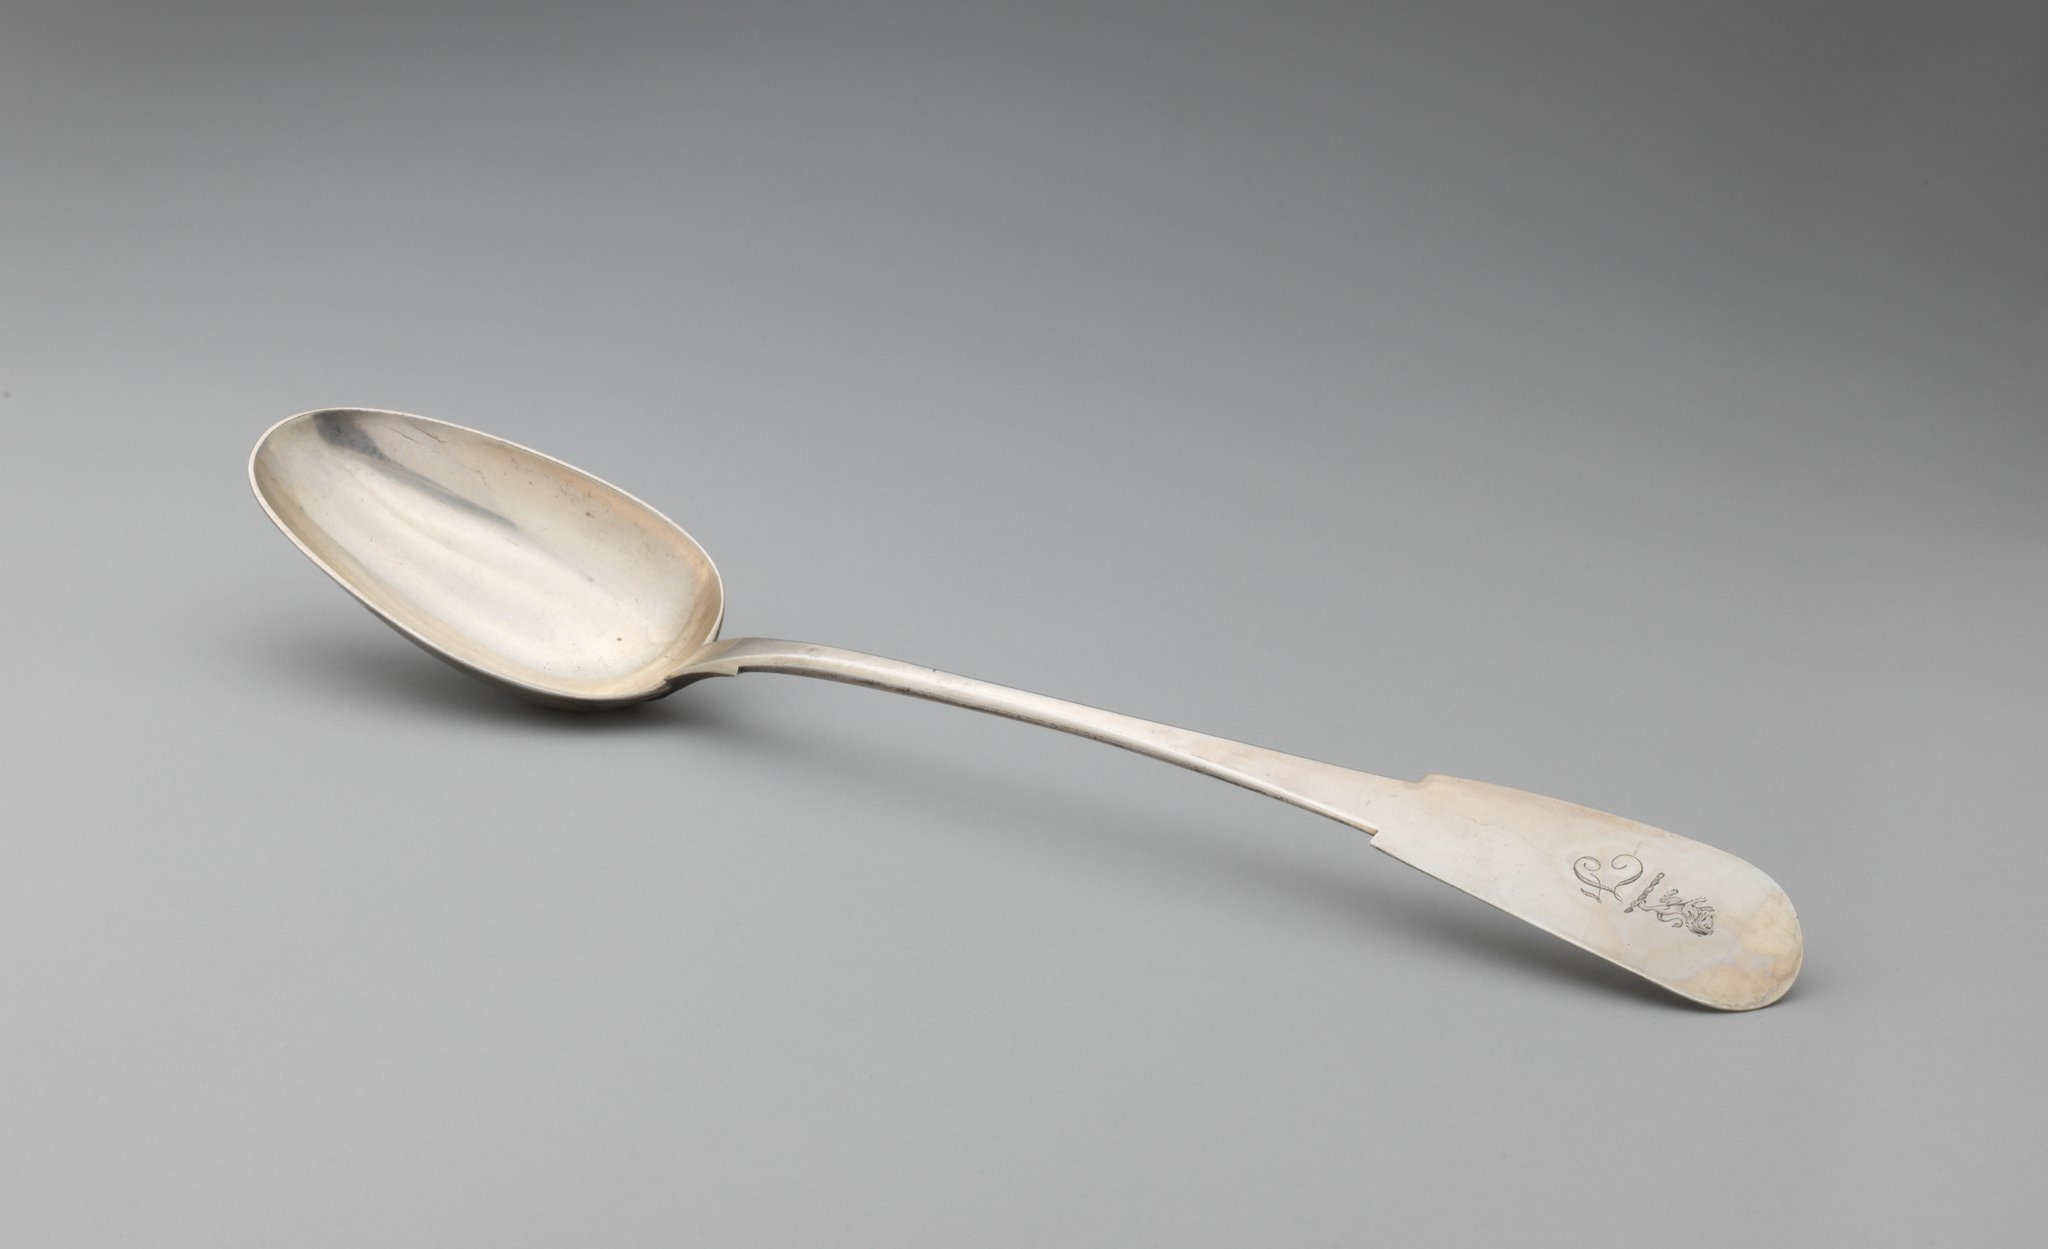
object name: gravy spoon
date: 1718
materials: silver